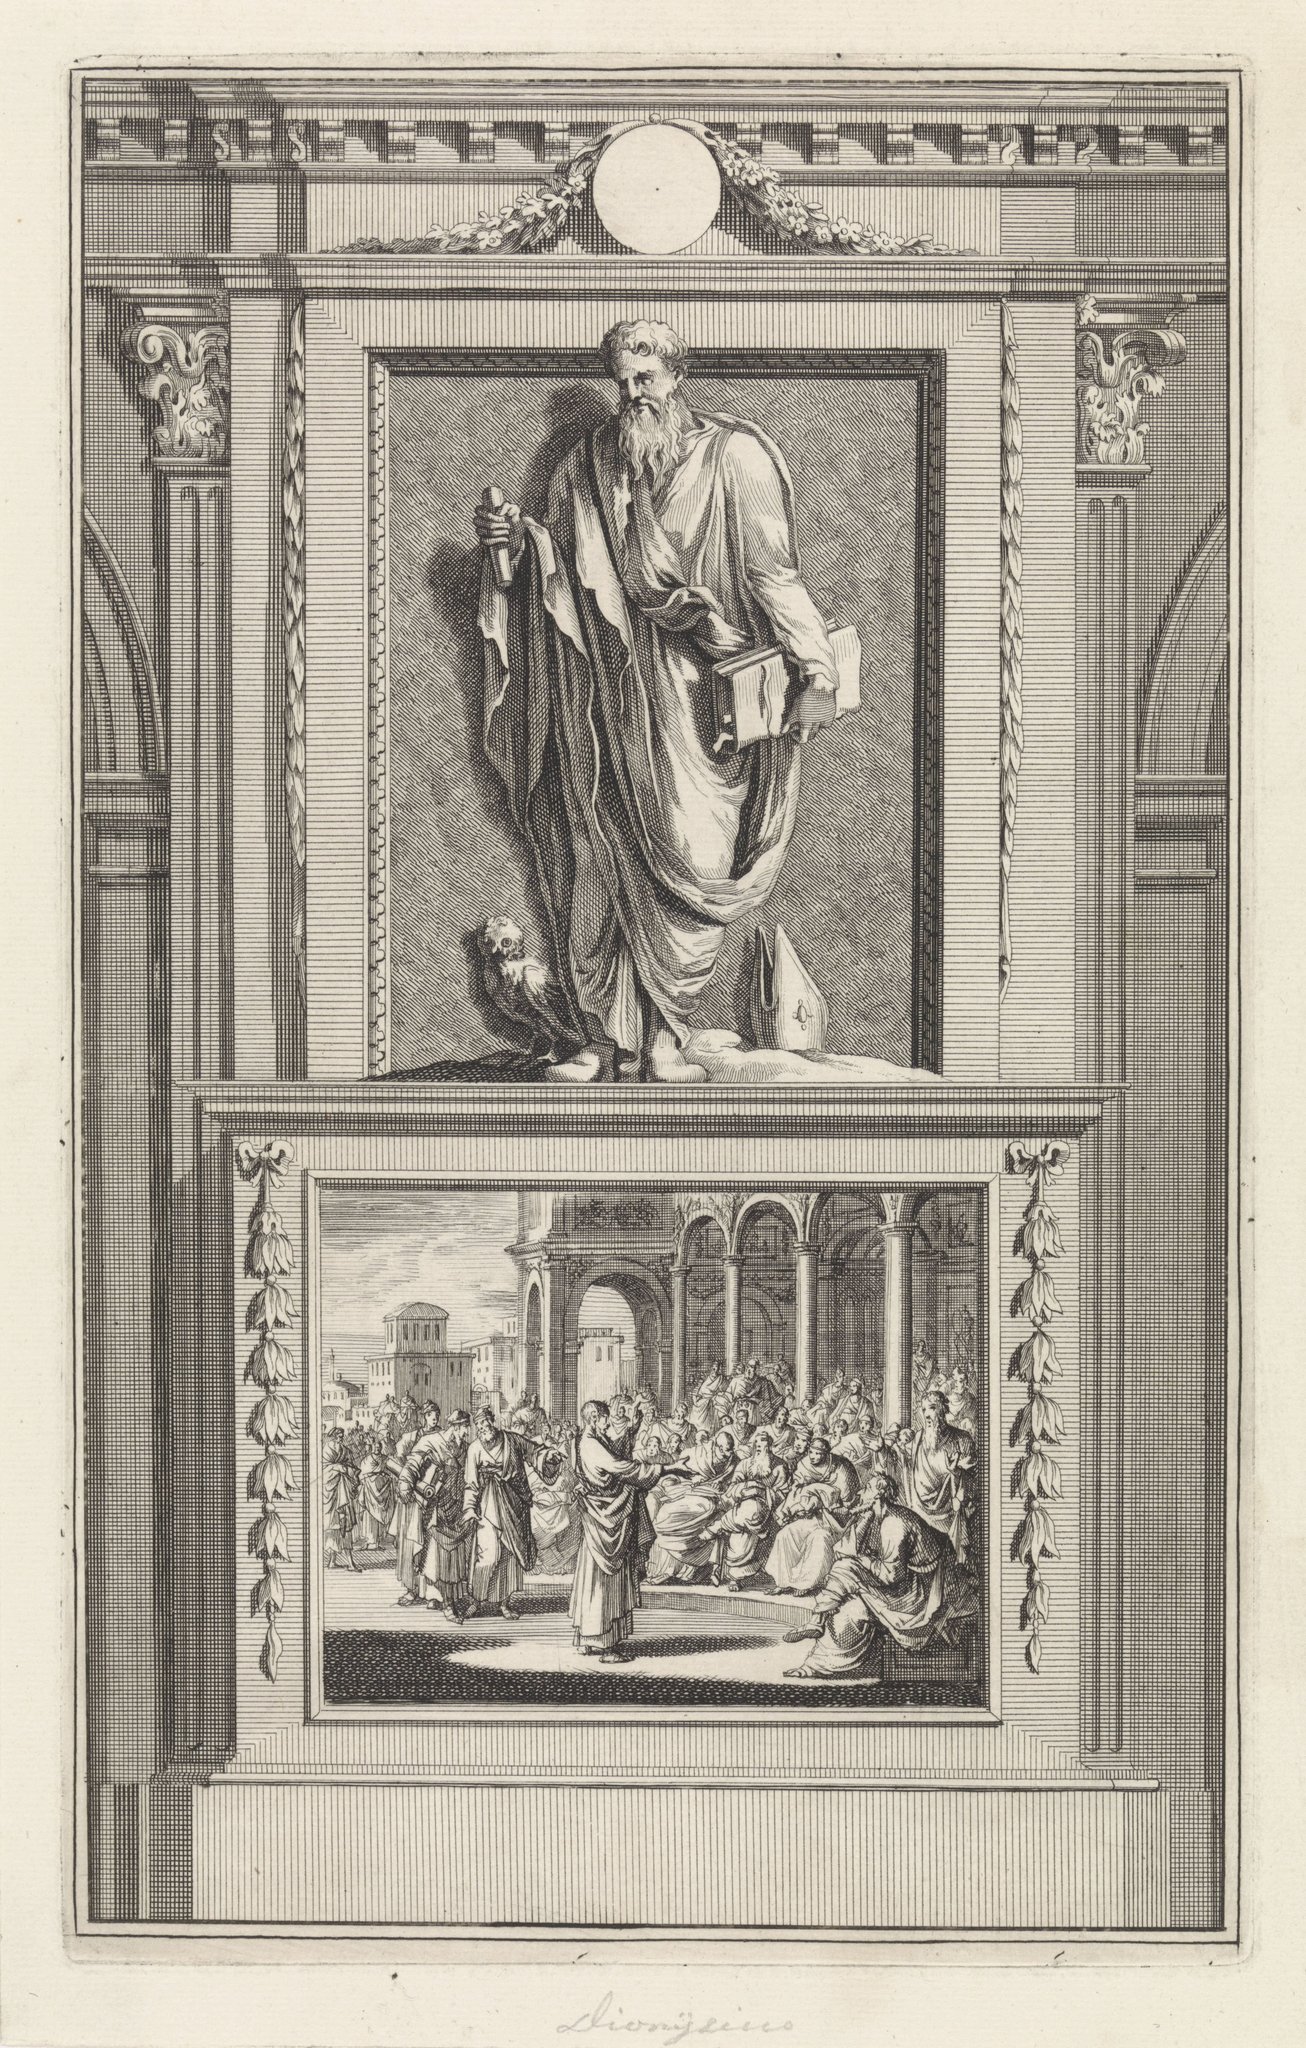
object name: print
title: H. Dionysius de Areopagiet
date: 1698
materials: paper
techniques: engraving, etching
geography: amsterdam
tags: the conversion of dionysius (denis) the areopagite, dionysius the areopagite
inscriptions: collector's mark: Lugt 2228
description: De heilige Dionysius de Areopagiet staat met een boek en een commandostaf in de handen. Aan zijn voeten een uil en een bisschopsmijter. Dionysius staat op een sokkel waar op de voorzijde zijn bekering tot het christendom in beeld is gebracht.